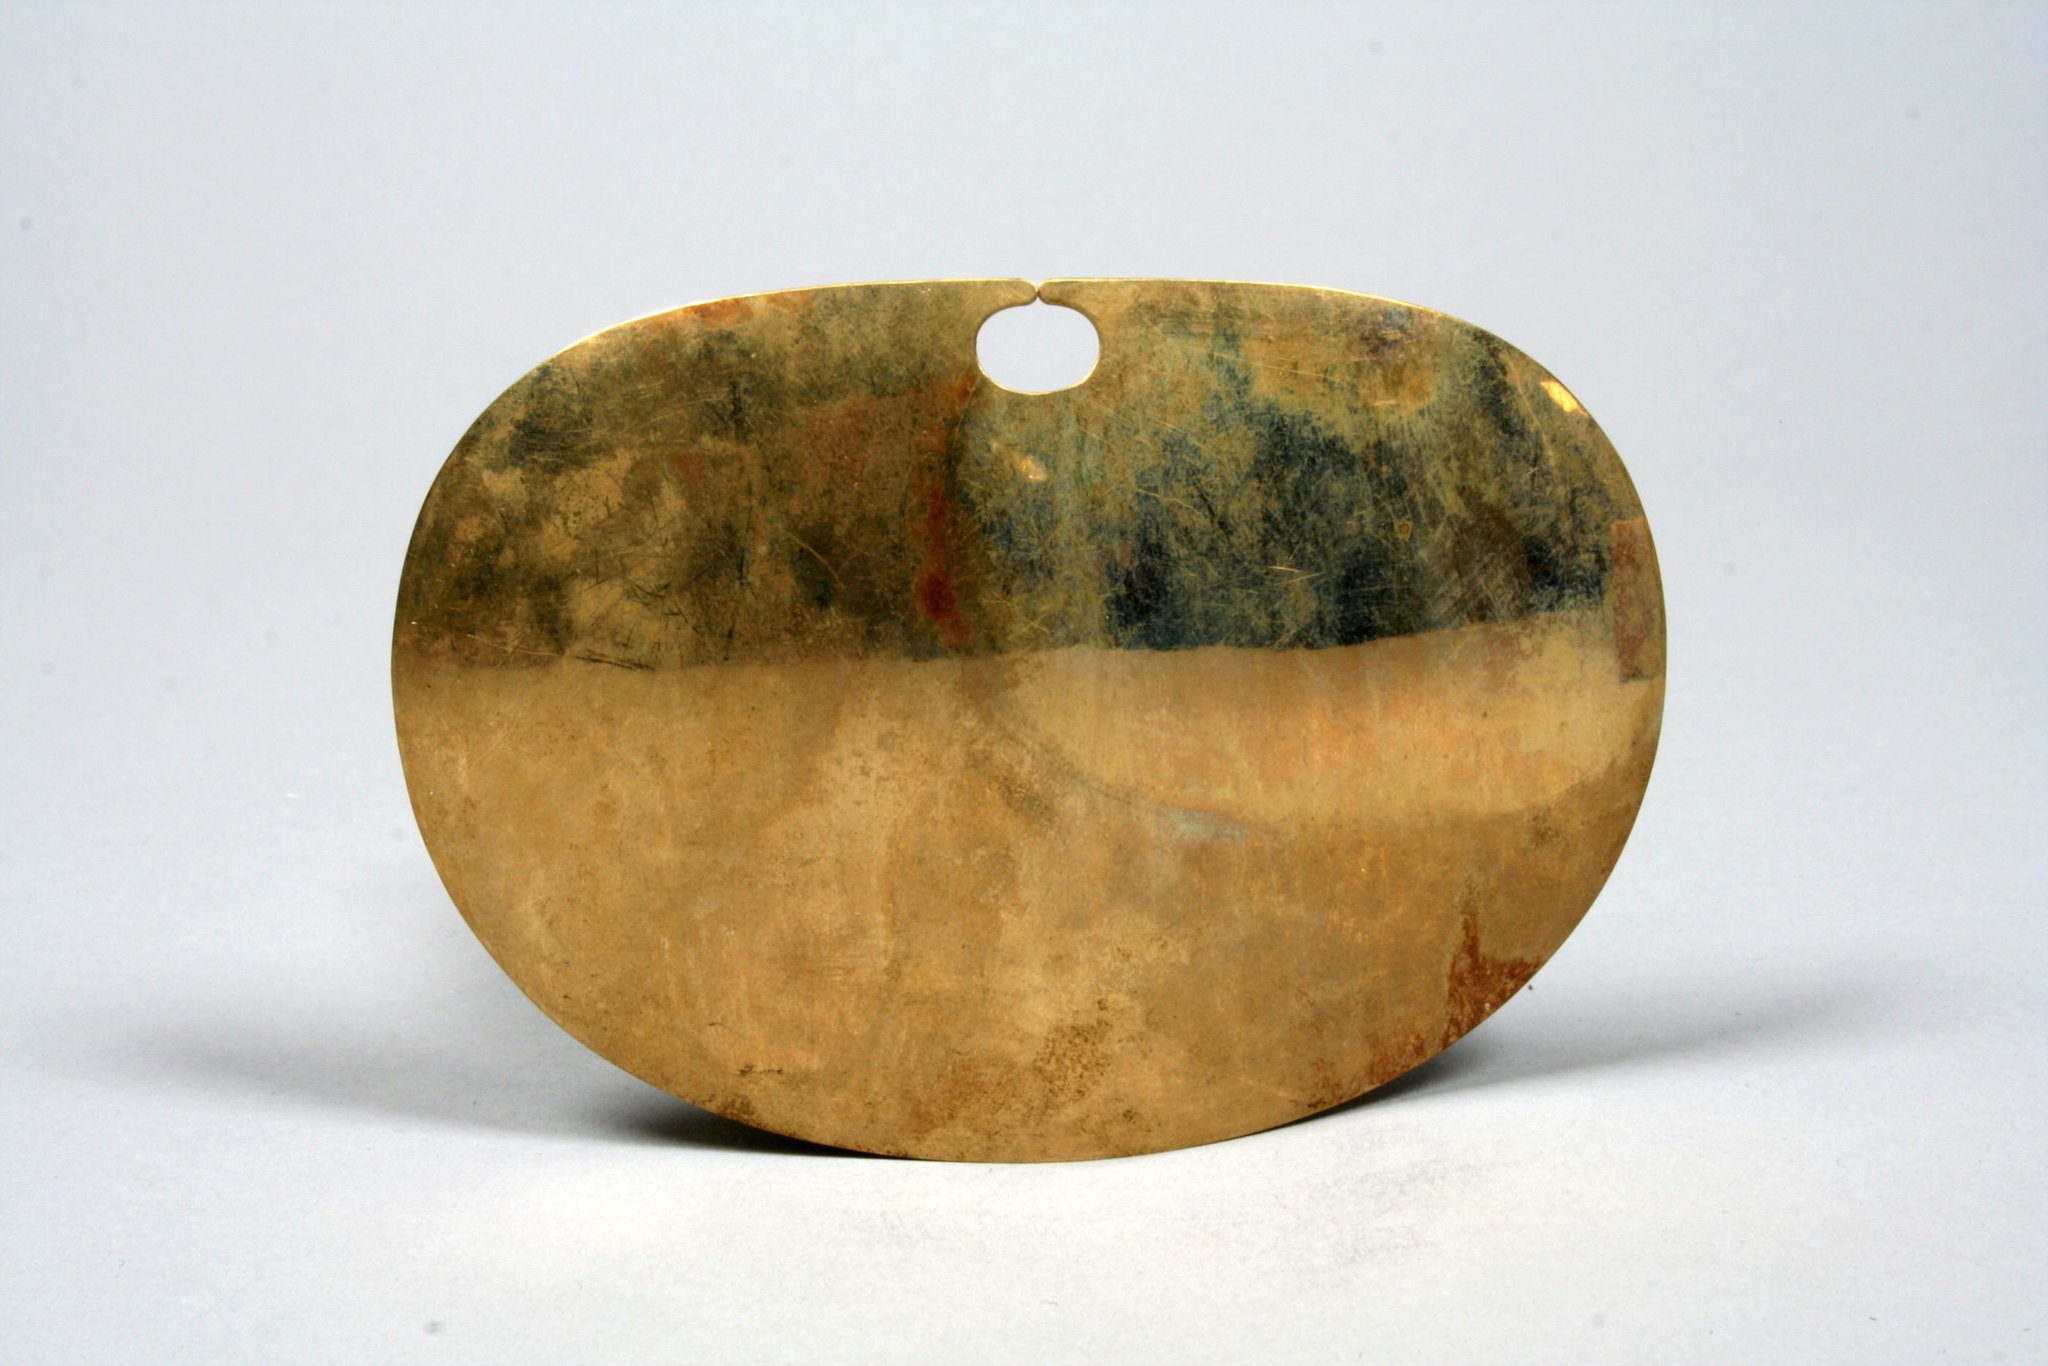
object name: nose ornament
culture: moche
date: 1-300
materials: gold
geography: peru